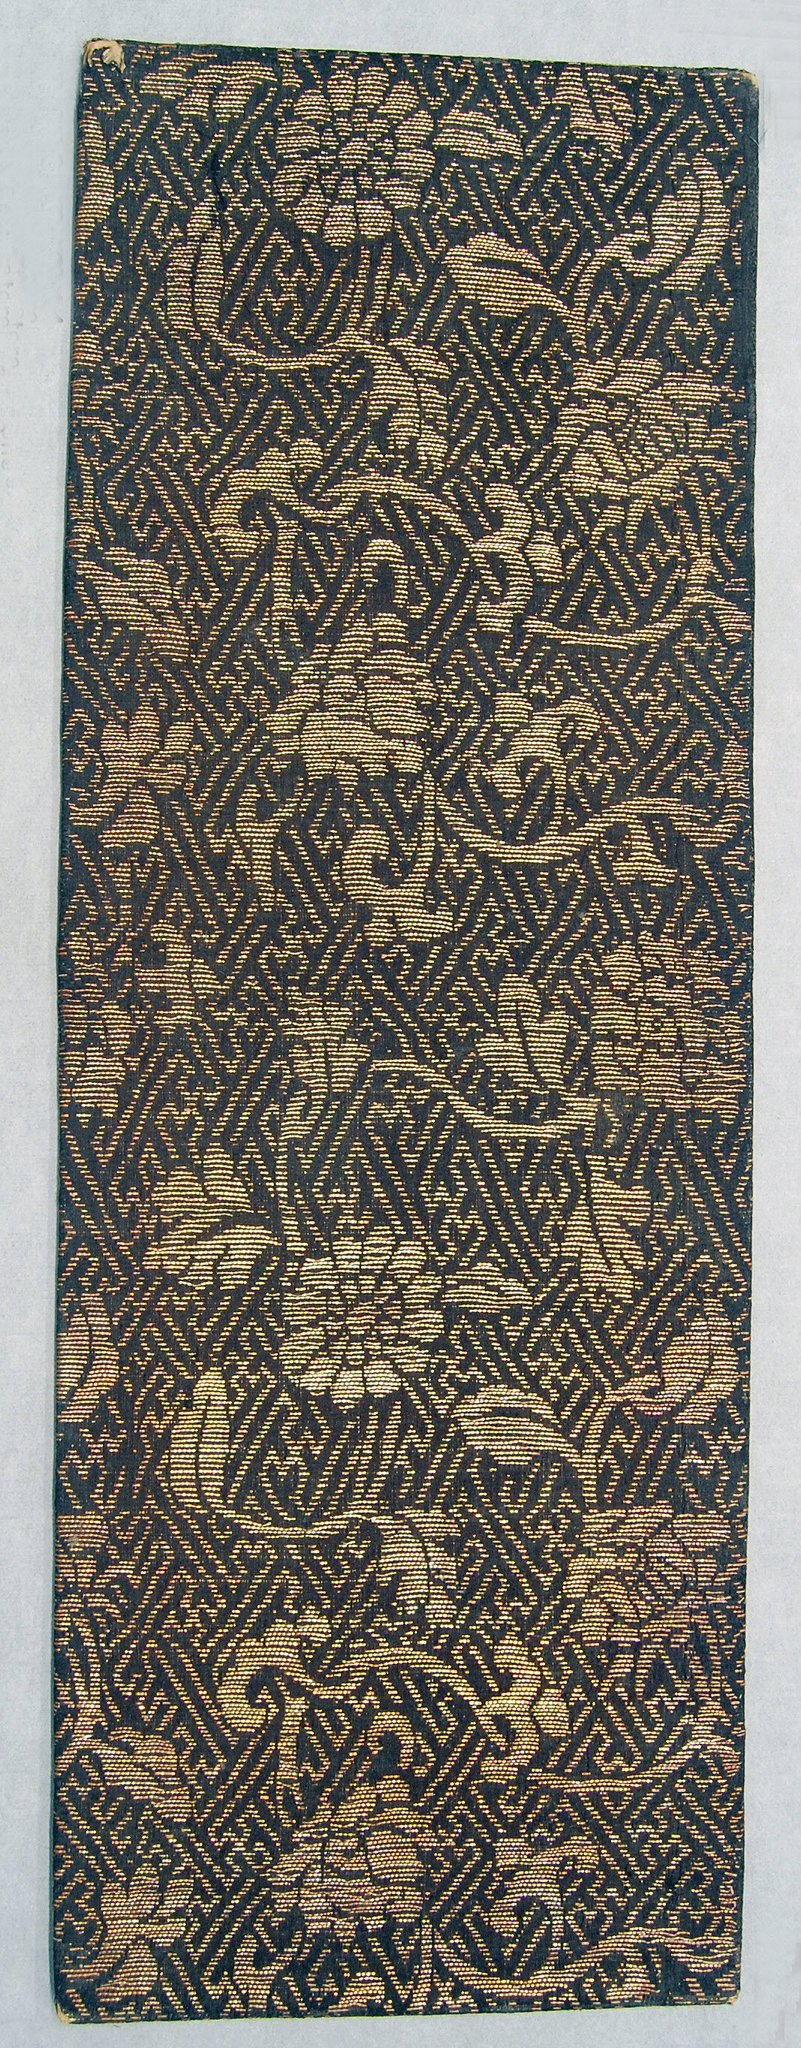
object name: sutra cover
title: Sutra Cover with Pattern of Various Flowers with Leaves and Scrolling Stems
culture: chinese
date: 1501-1600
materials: metal thread, silk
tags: flowers,leaves